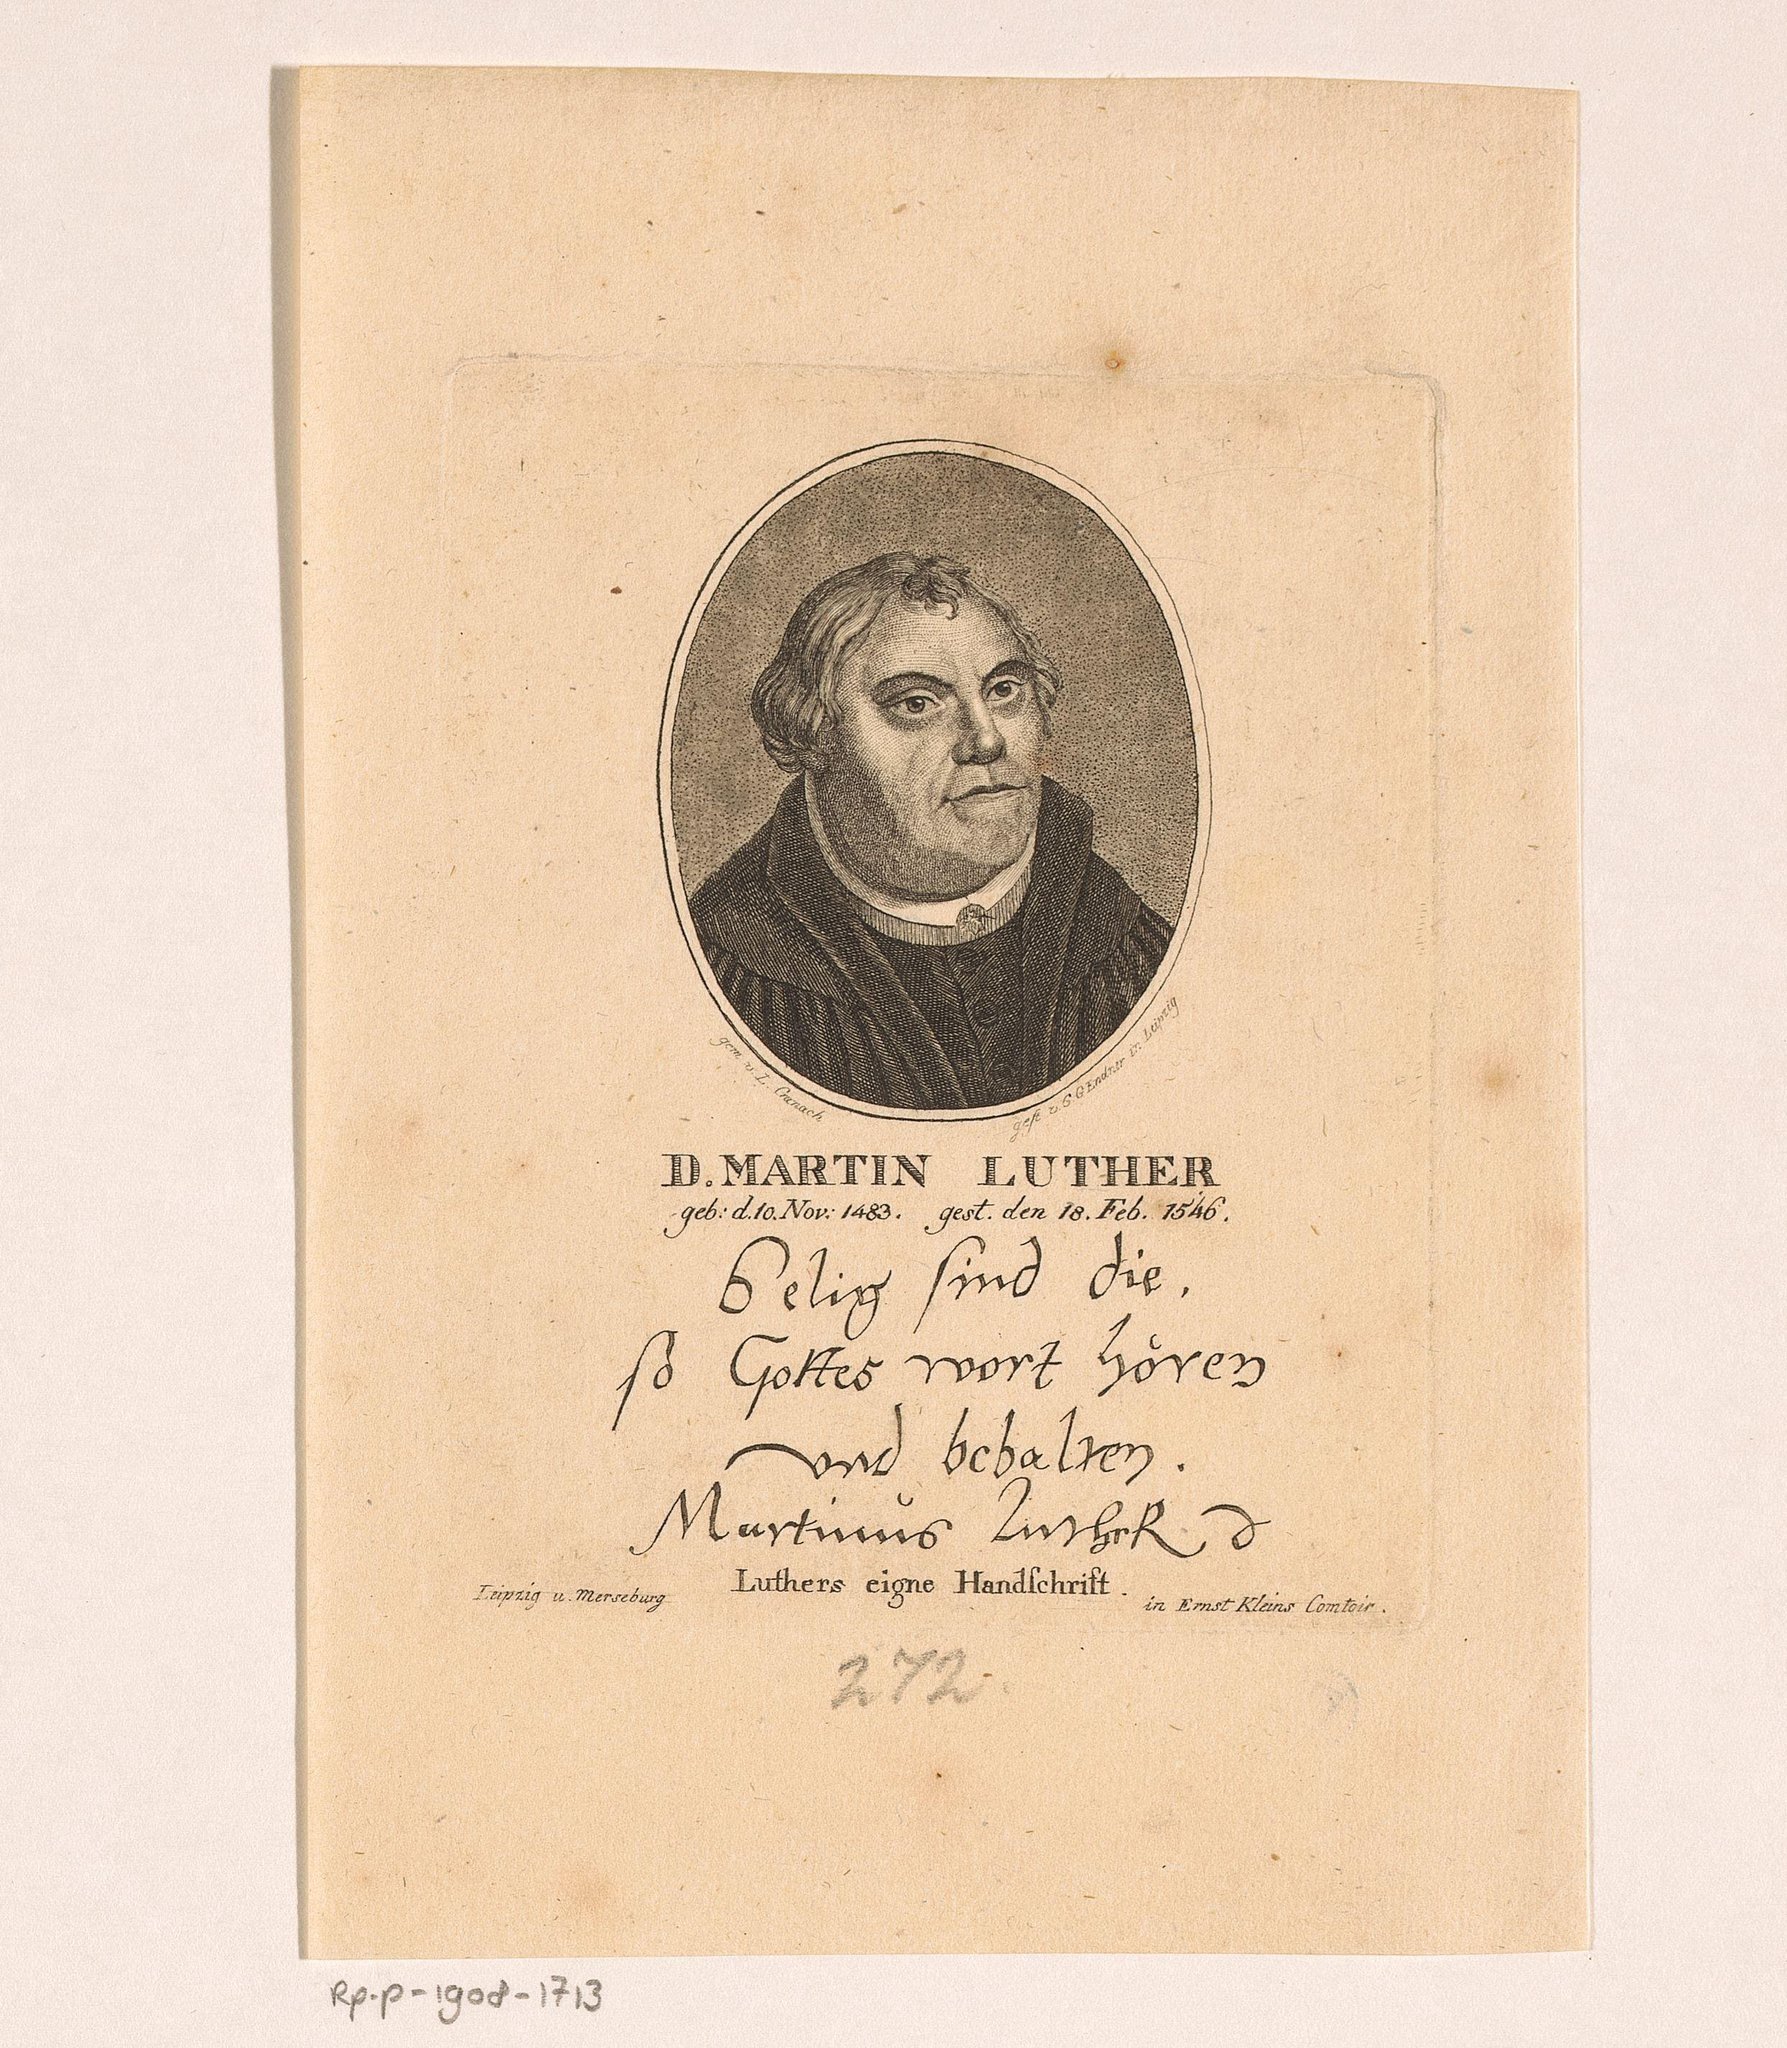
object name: print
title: Portret van Martin Luther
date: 1764-1824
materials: paper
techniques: engraving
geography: leipzig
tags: priest, martin luther, historical persons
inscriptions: collector's mark: Lugt 2228, collector's mark: Lugt 1388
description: Met onderschrift naar het handschrift van Luther.